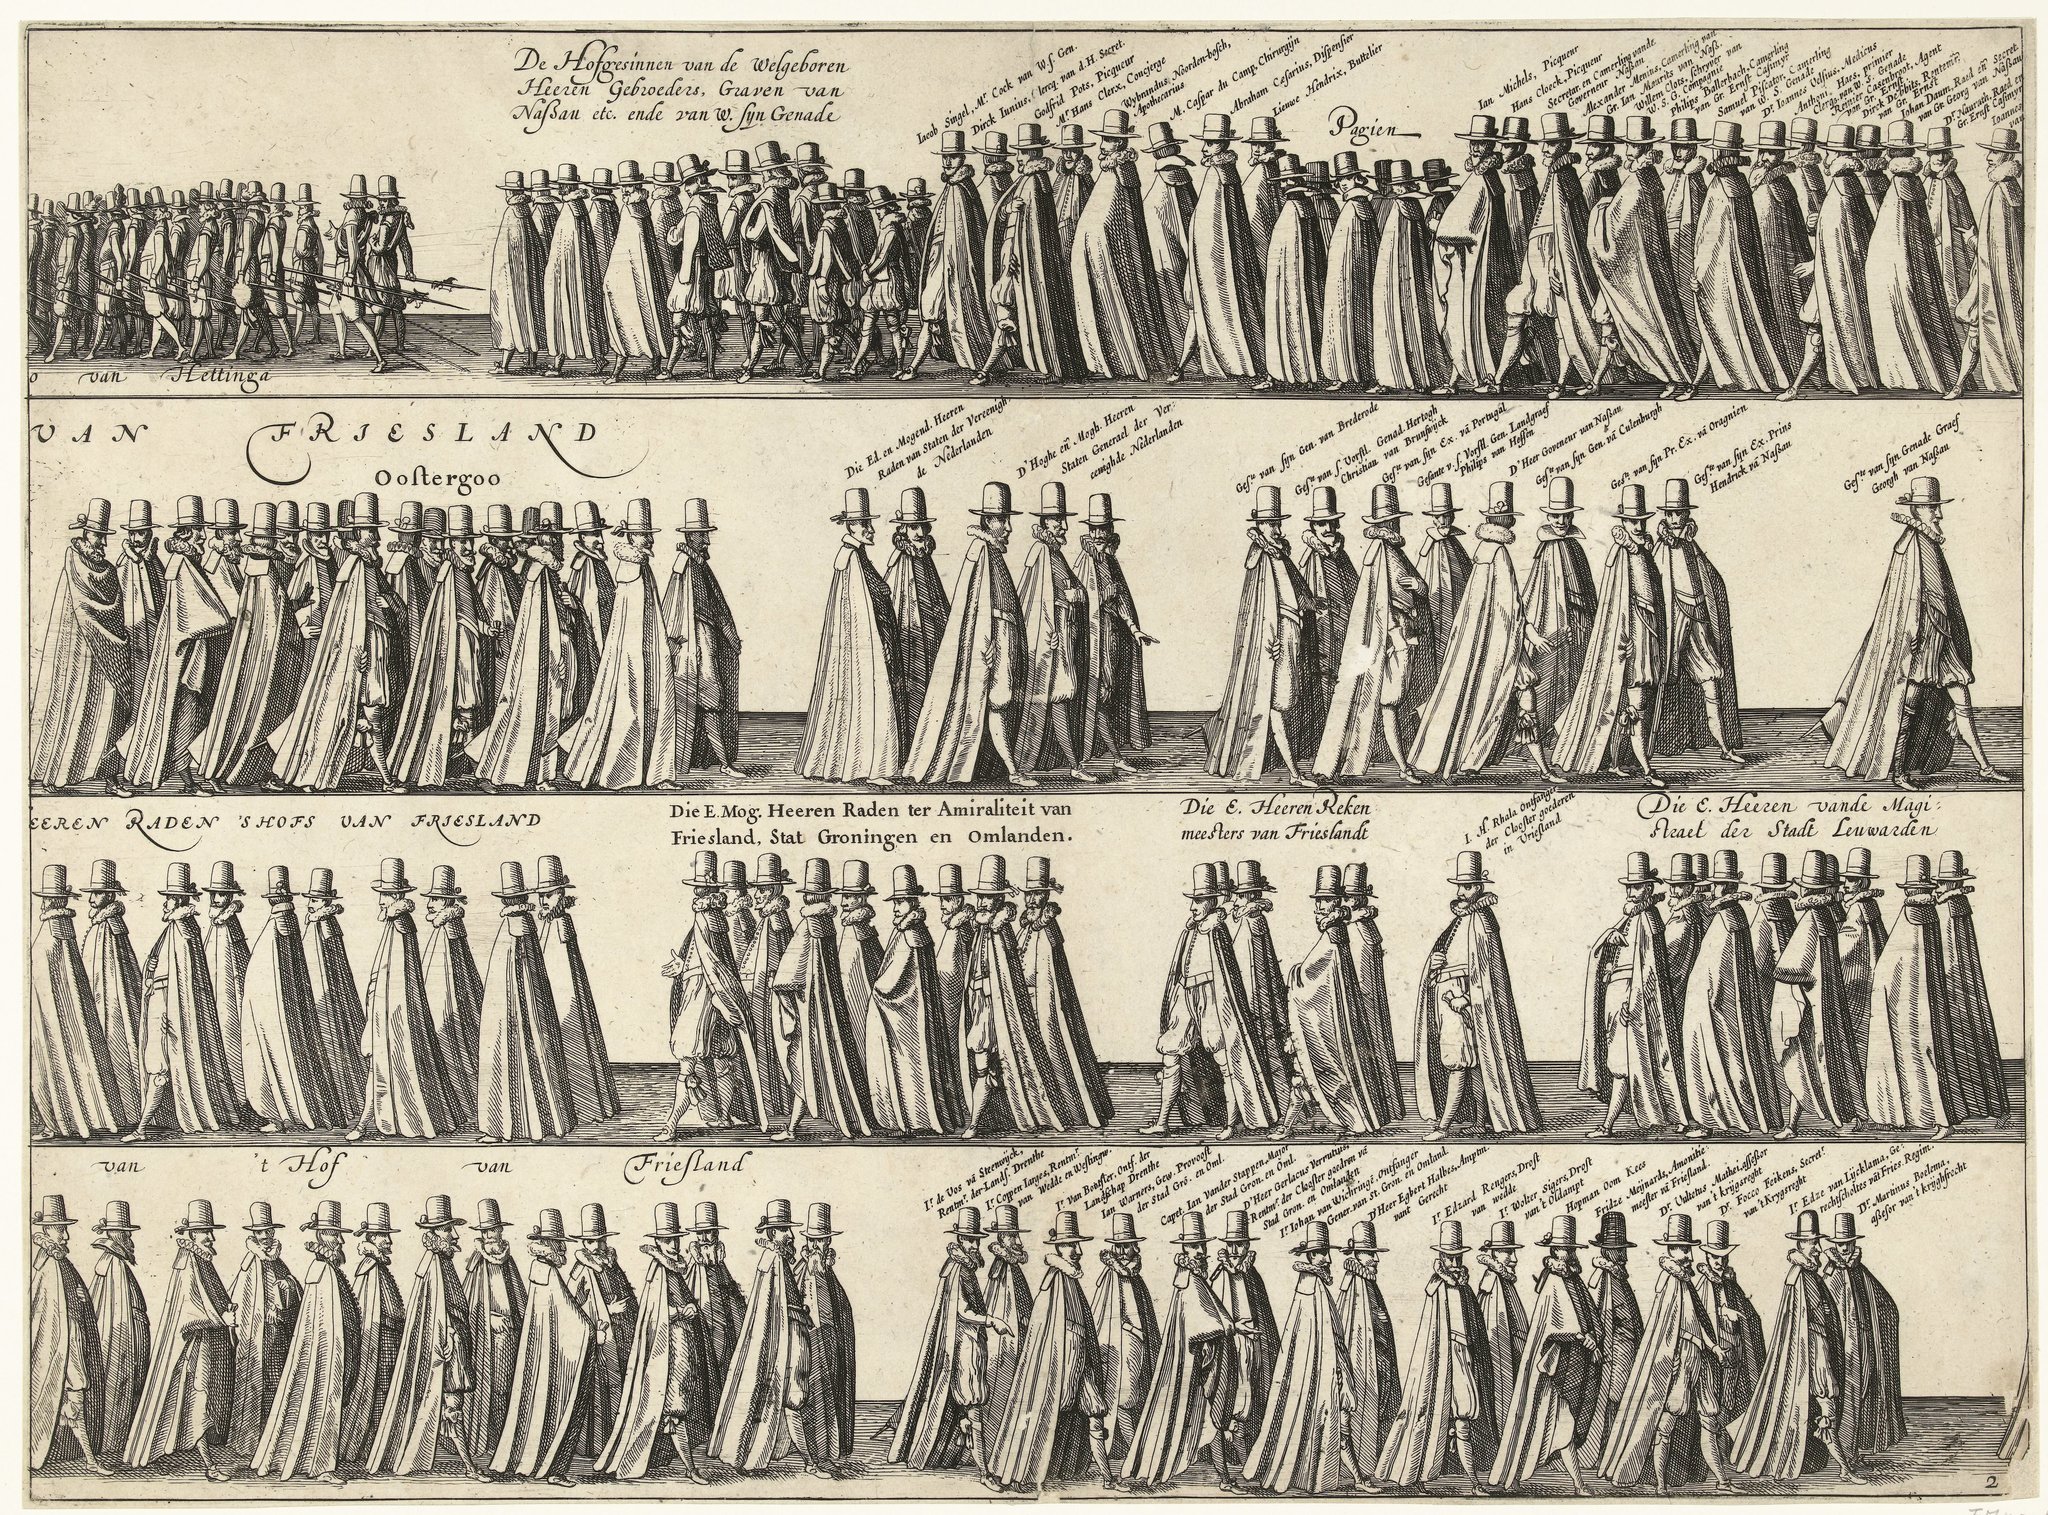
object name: print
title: Begrafenis van Willem Lodewijk, 1620 (blad 2)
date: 1620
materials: paper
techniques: etching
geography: northern netherlands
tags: willem lodewijk graaf van nassau-dillenburg, cortege, funeral procession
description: Begrafenis van Willem Lodewijk, graaf van Nassau, in de Grote Kerk te Leeuwarden op 13 juli 1620, blad 2. Blad met de deelnemers aan de begrafenisstoet, met naam.